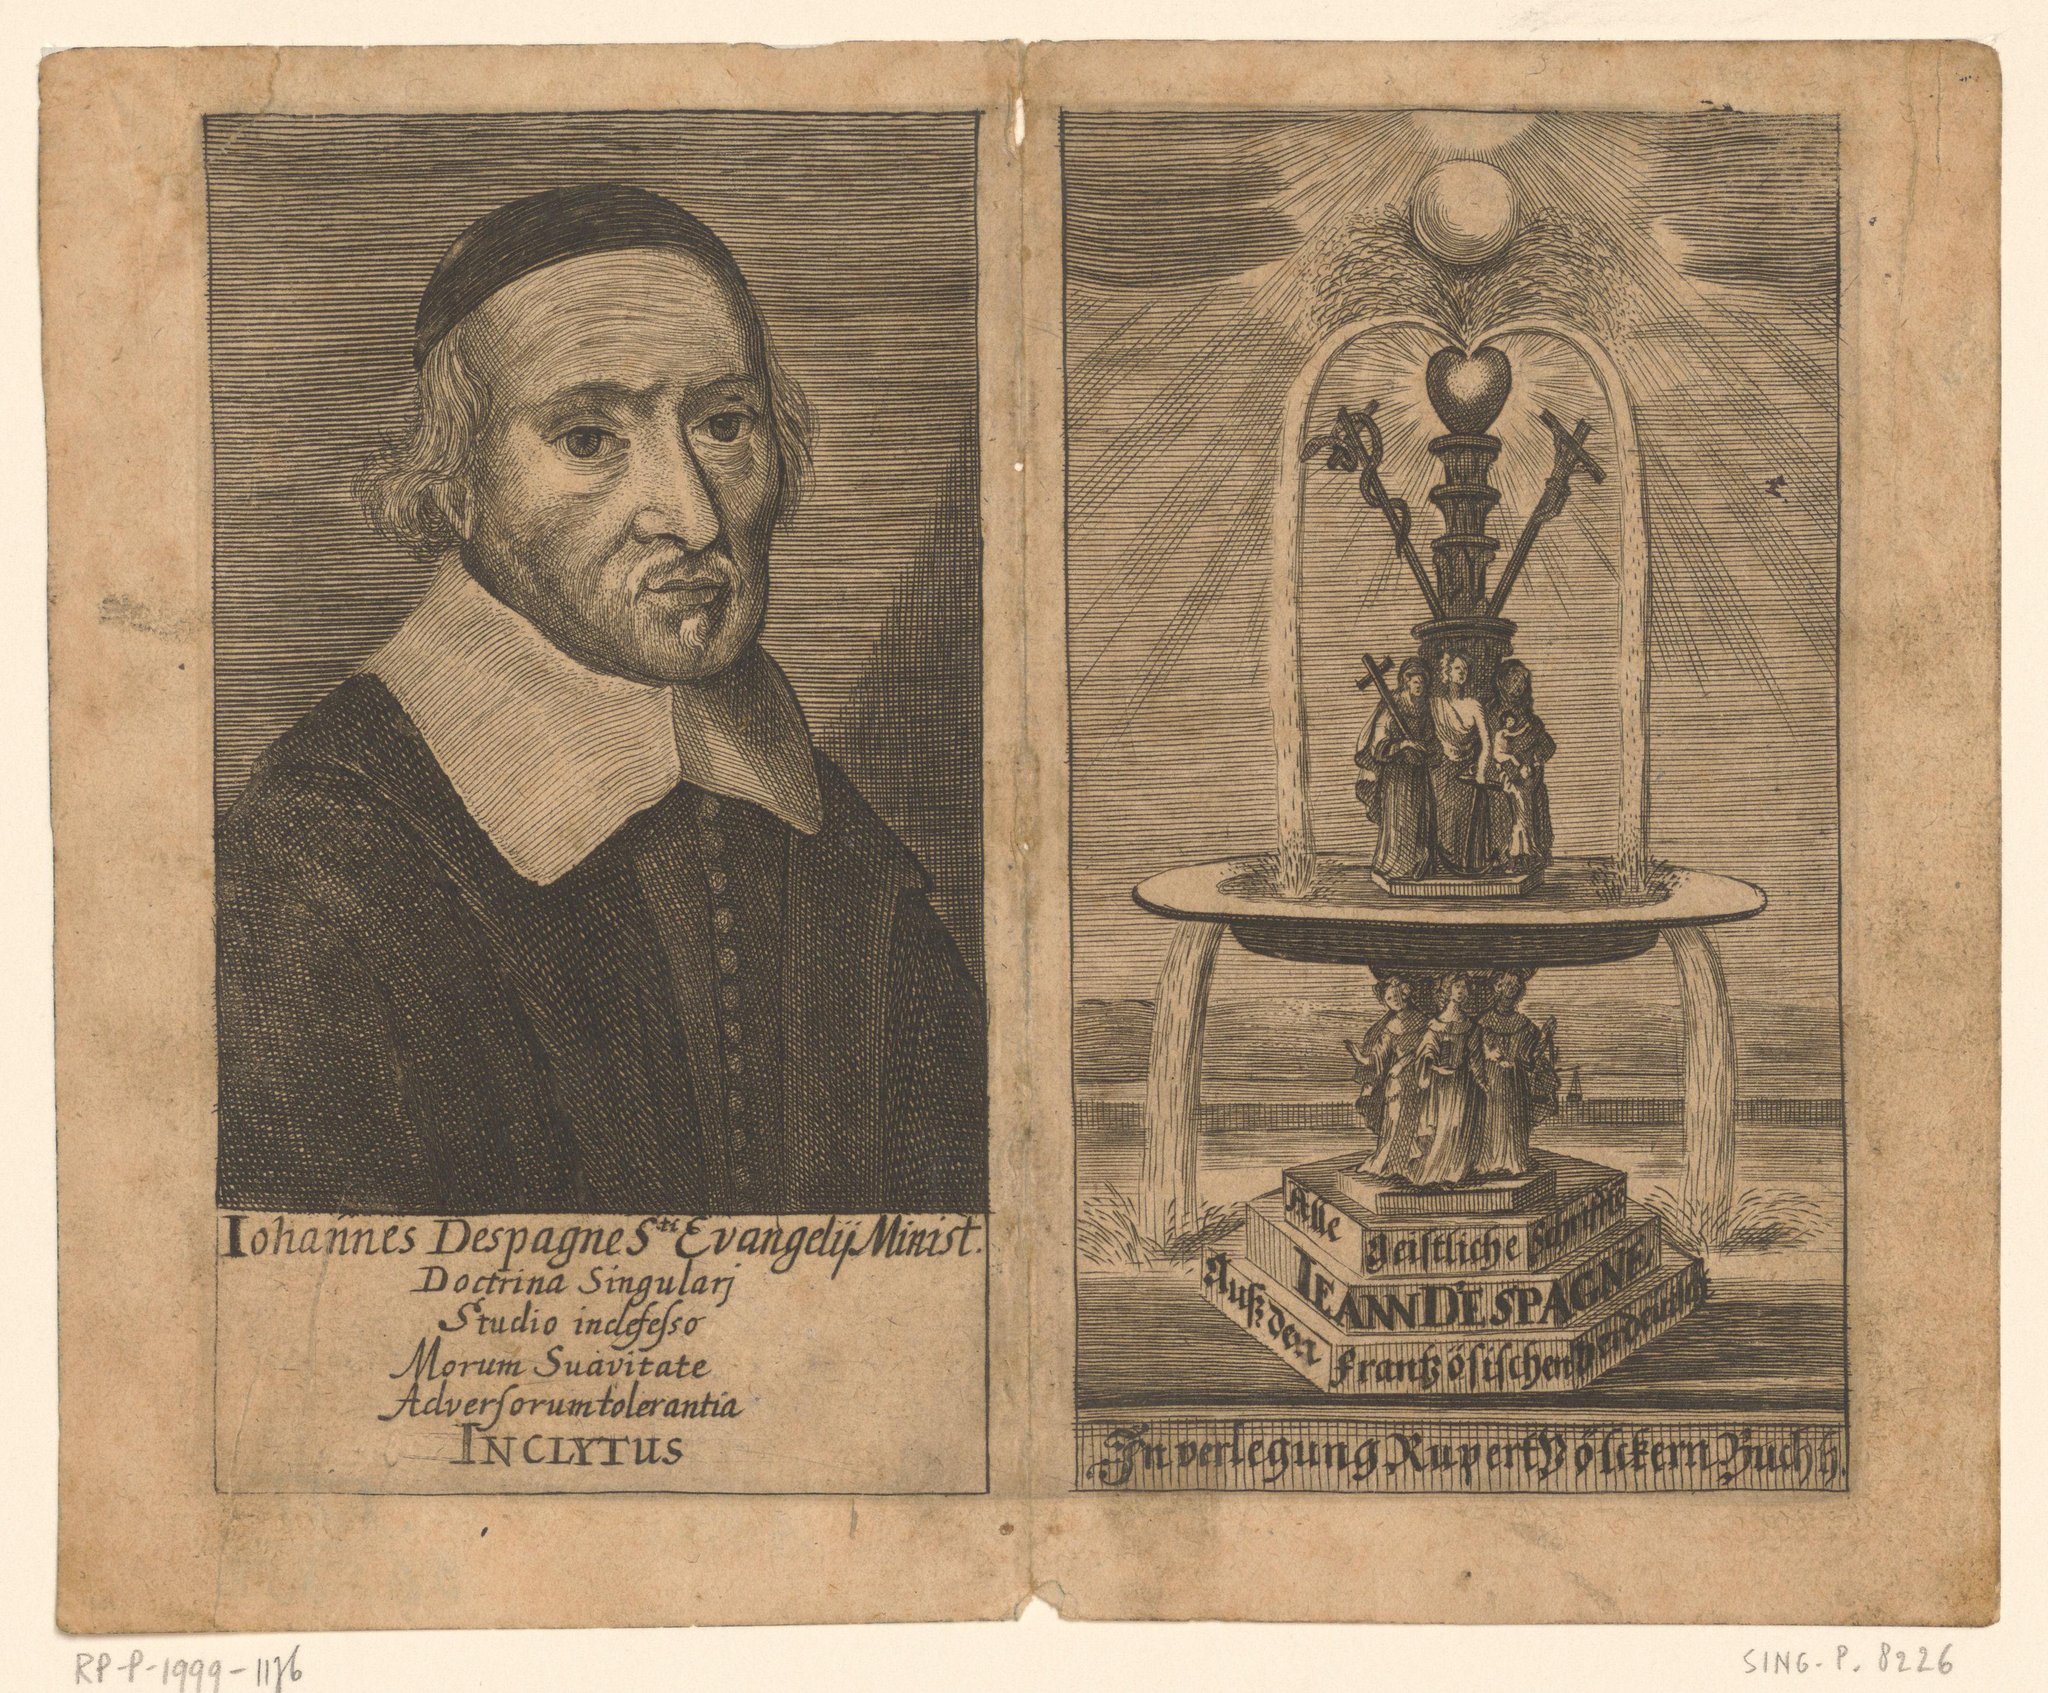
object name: print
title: Portret van Johannes Despagne met naast hem een fontein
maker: Anonymous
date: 1677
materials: paper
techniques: engraving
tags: theologian, historical persons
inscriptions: inscription: ‘Portr. 54348’, collector's mark: Lugt 2228, collector's mark: Lugt 2760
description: Prent mogelijk uit: Espagne, Jean d’. Neue Anmerckungen Uber die Zehen Gebote. Berlijn: Rupert Völcker, 1677.